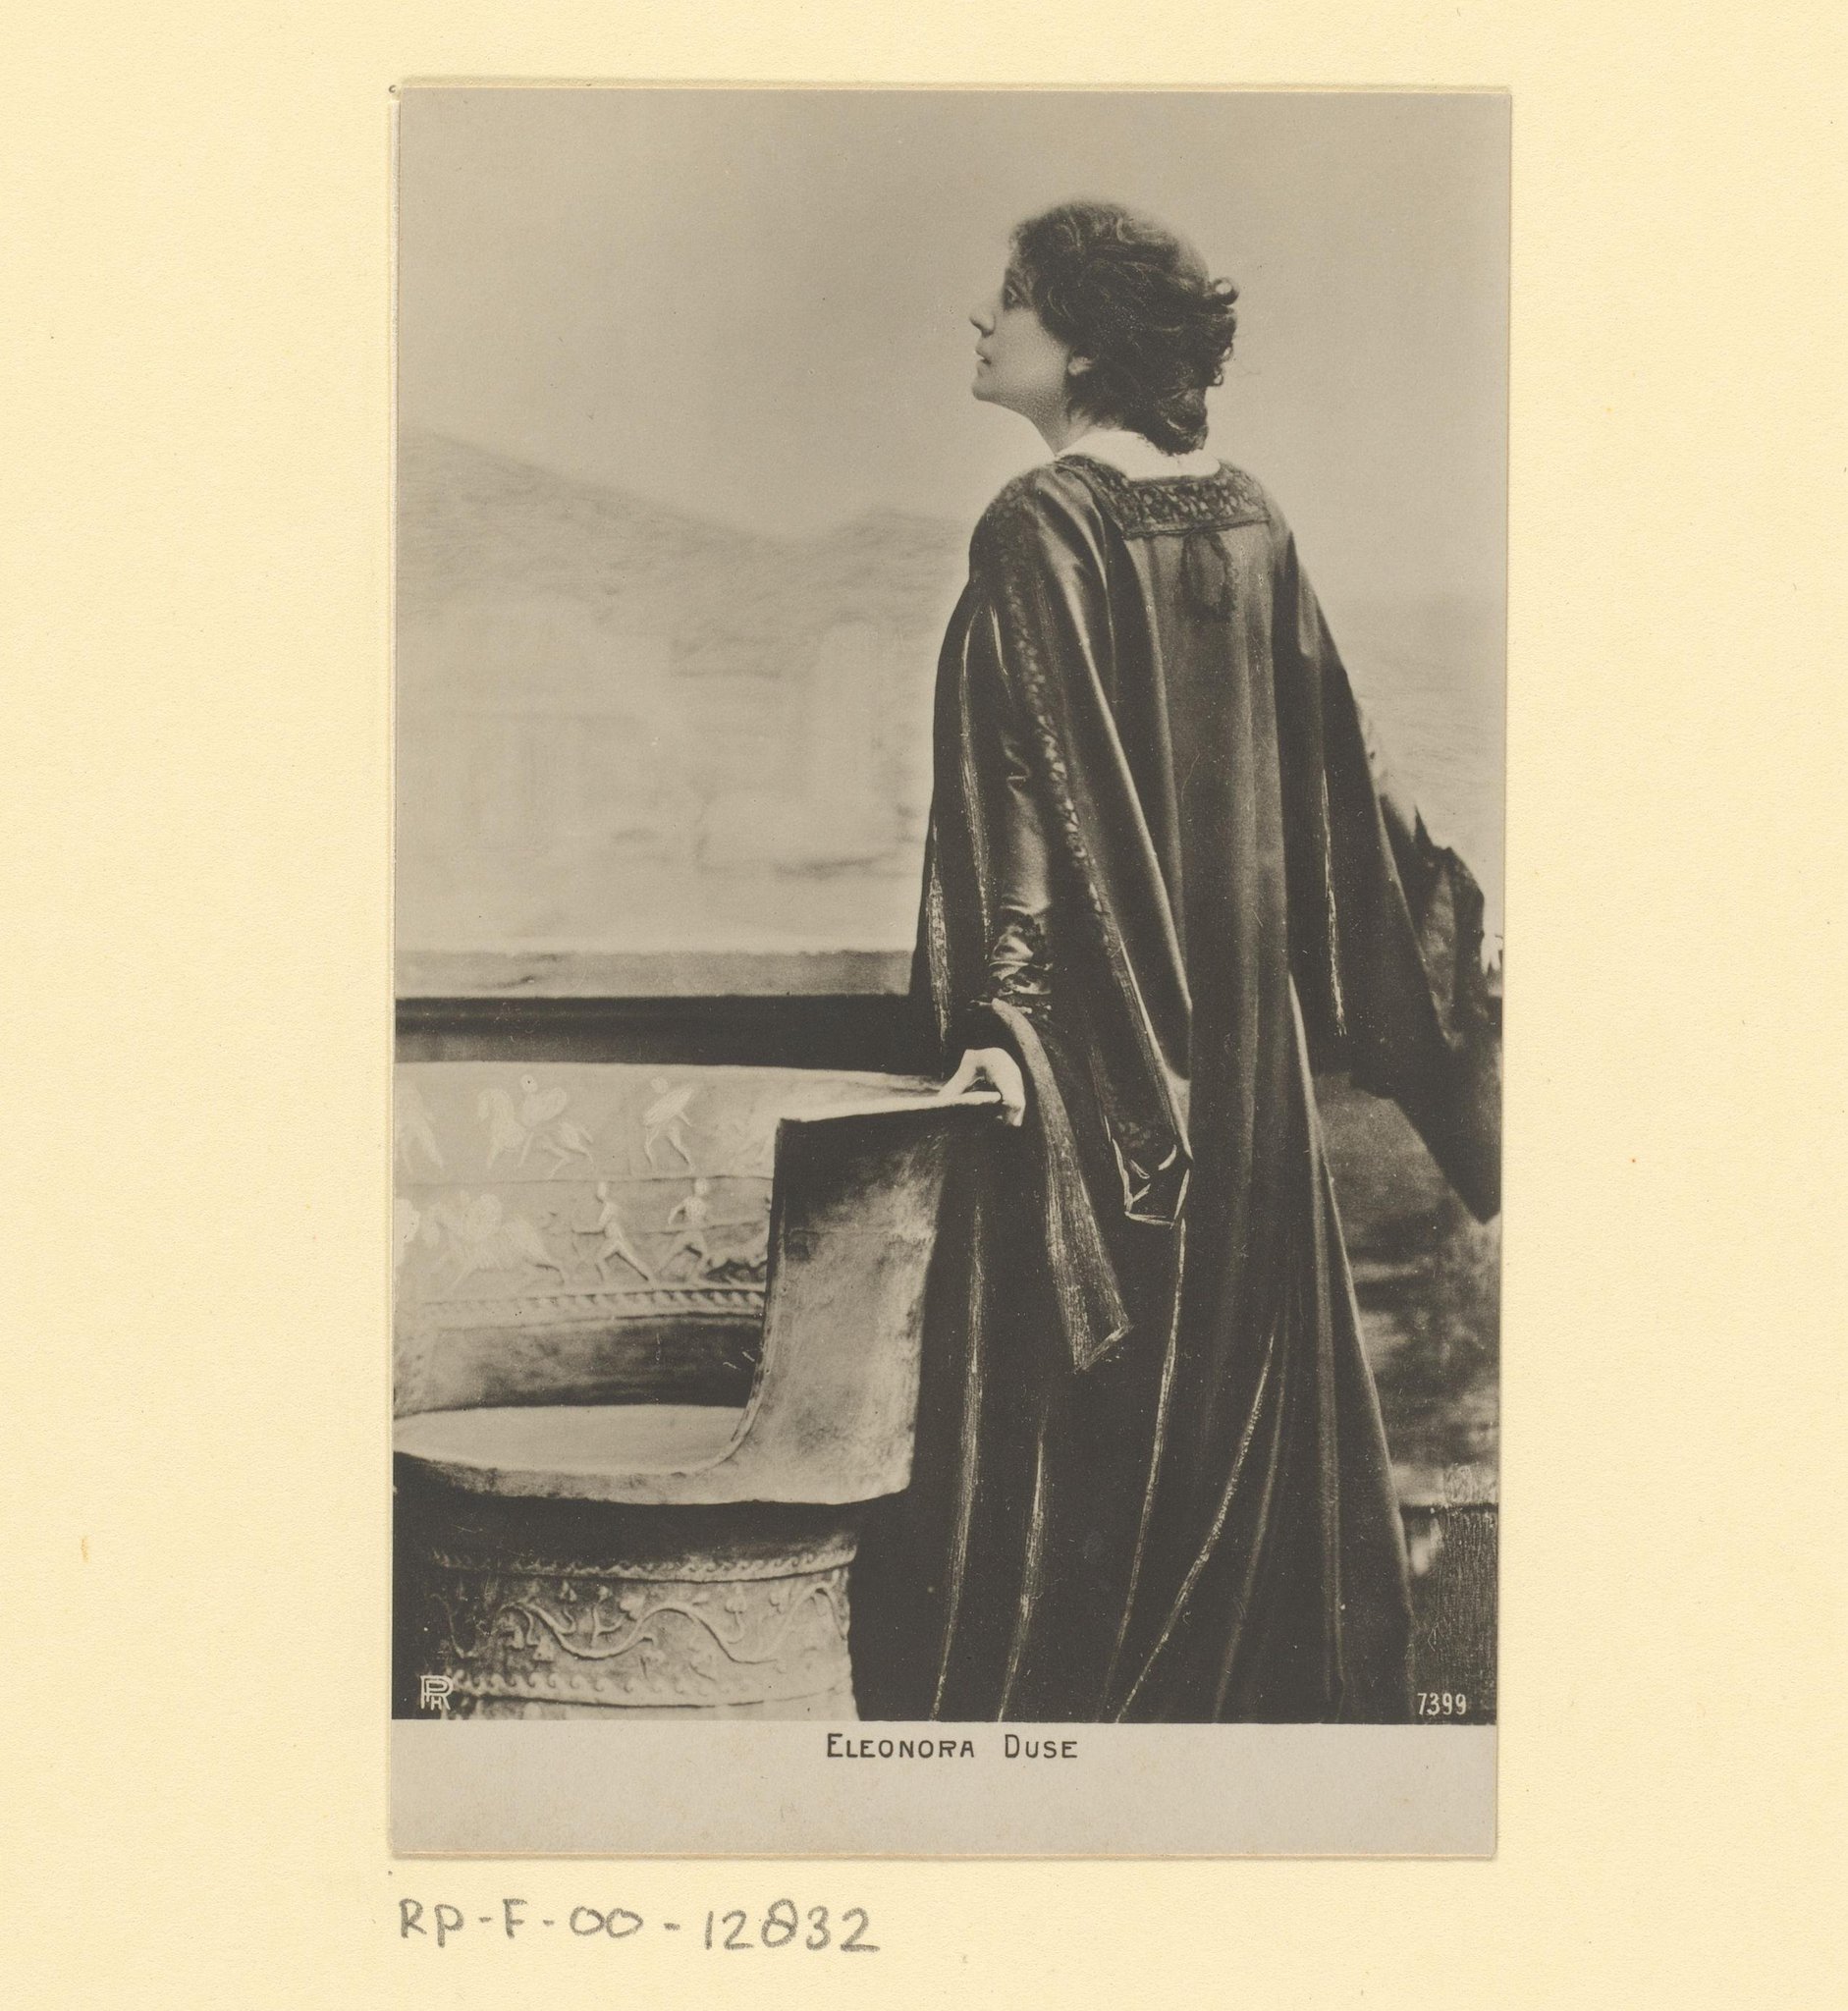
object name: ansichtkaart, prentbriefkaart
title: Eleonora Duse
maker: Anonymous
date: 1890-1905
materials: paper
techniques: gelatin silver print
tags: portrait of actor, actress